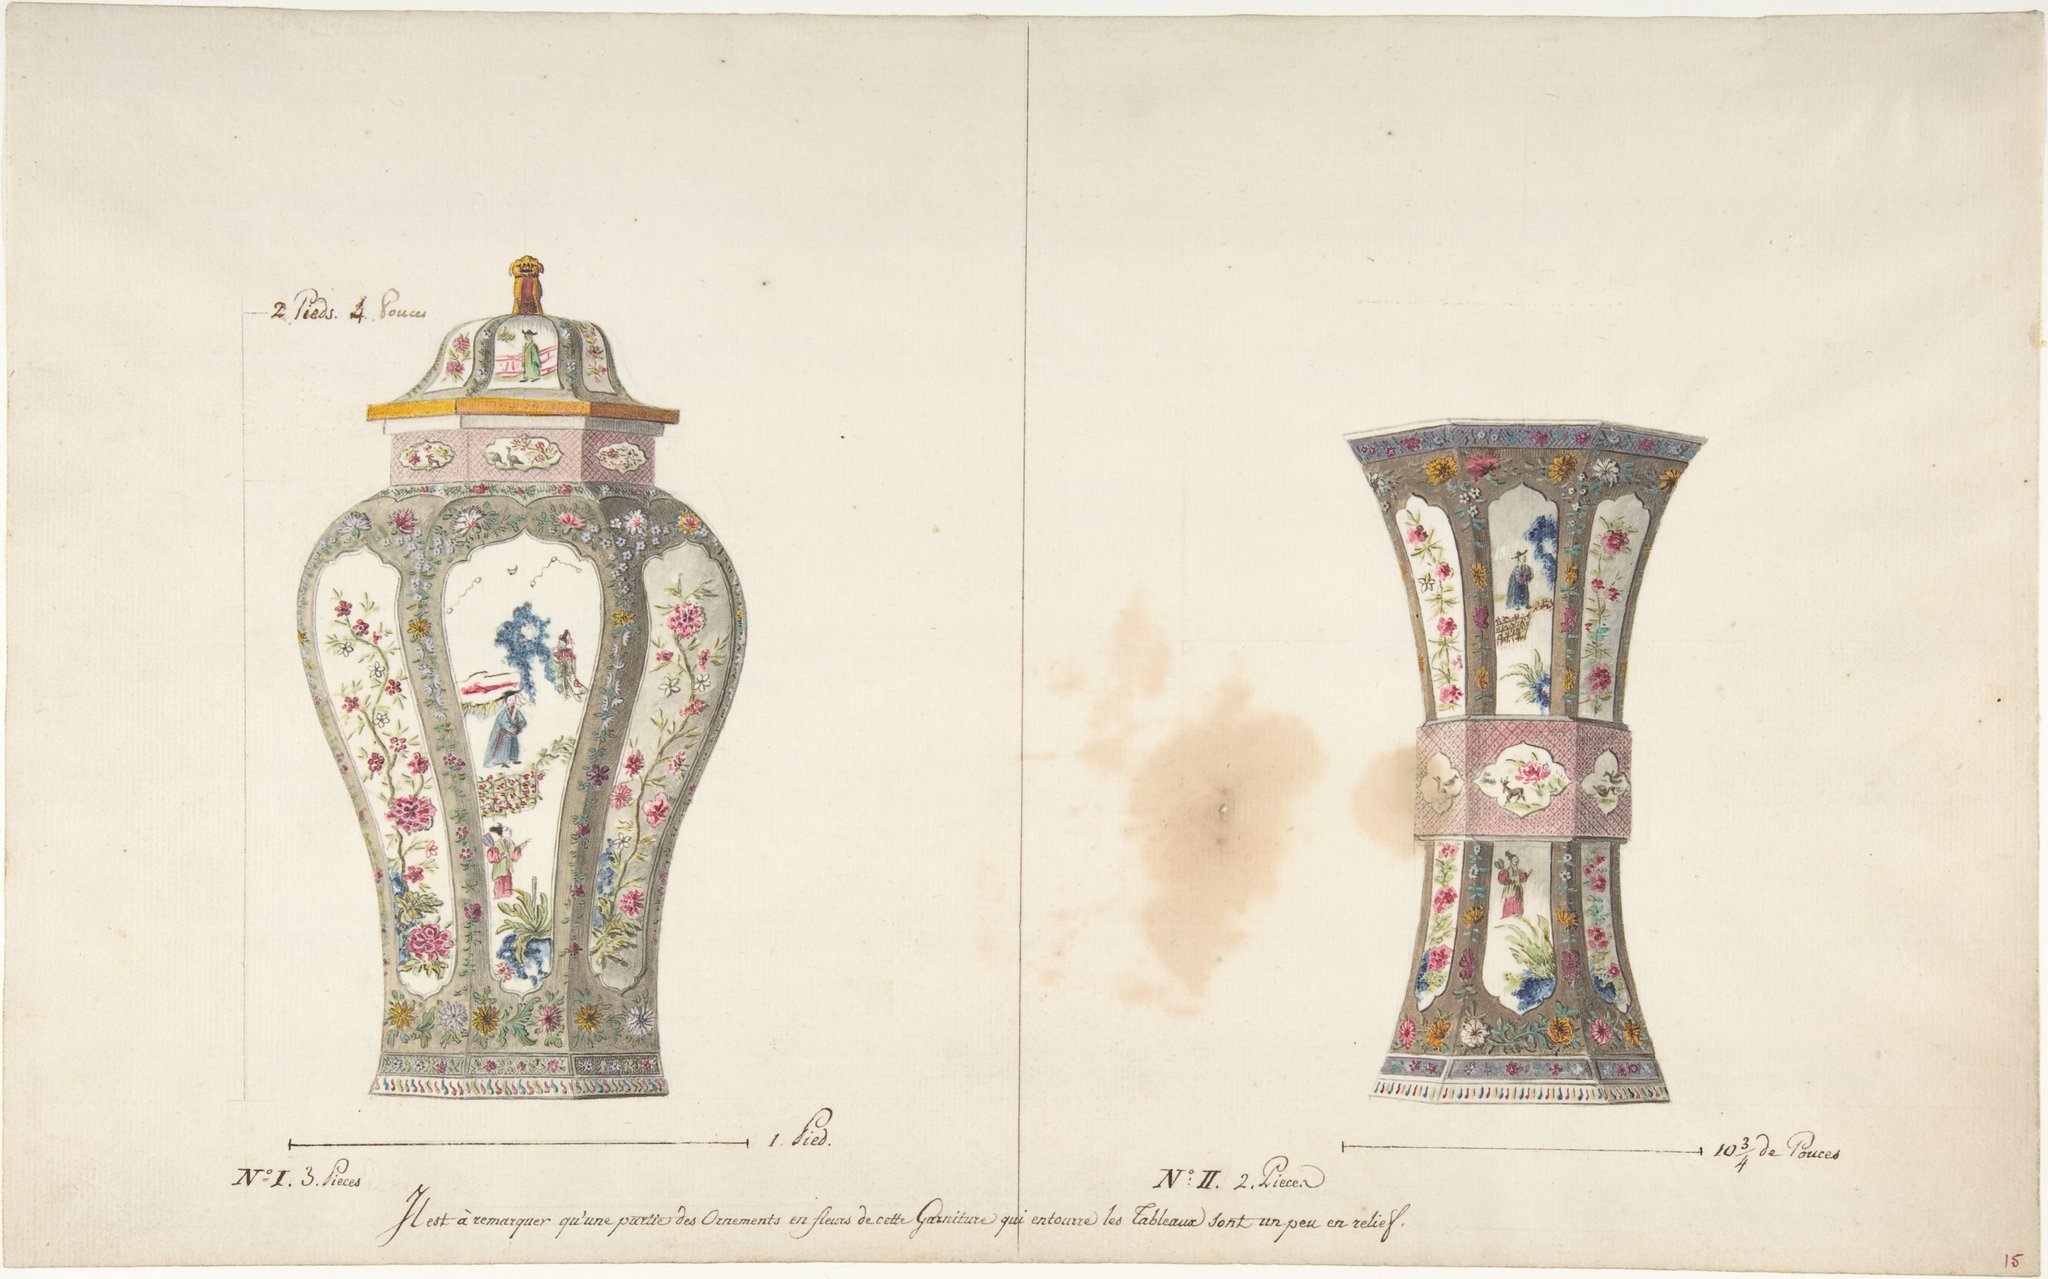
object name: drawing ornament architecture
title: Designs for Two Porcelain Vases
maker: anonymous, french, 18th century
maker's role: artist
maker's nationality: french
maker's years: 1700-1800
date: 1770-1785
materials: graphite, ink, watercolor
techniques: pen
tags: human figures,flowers,vases